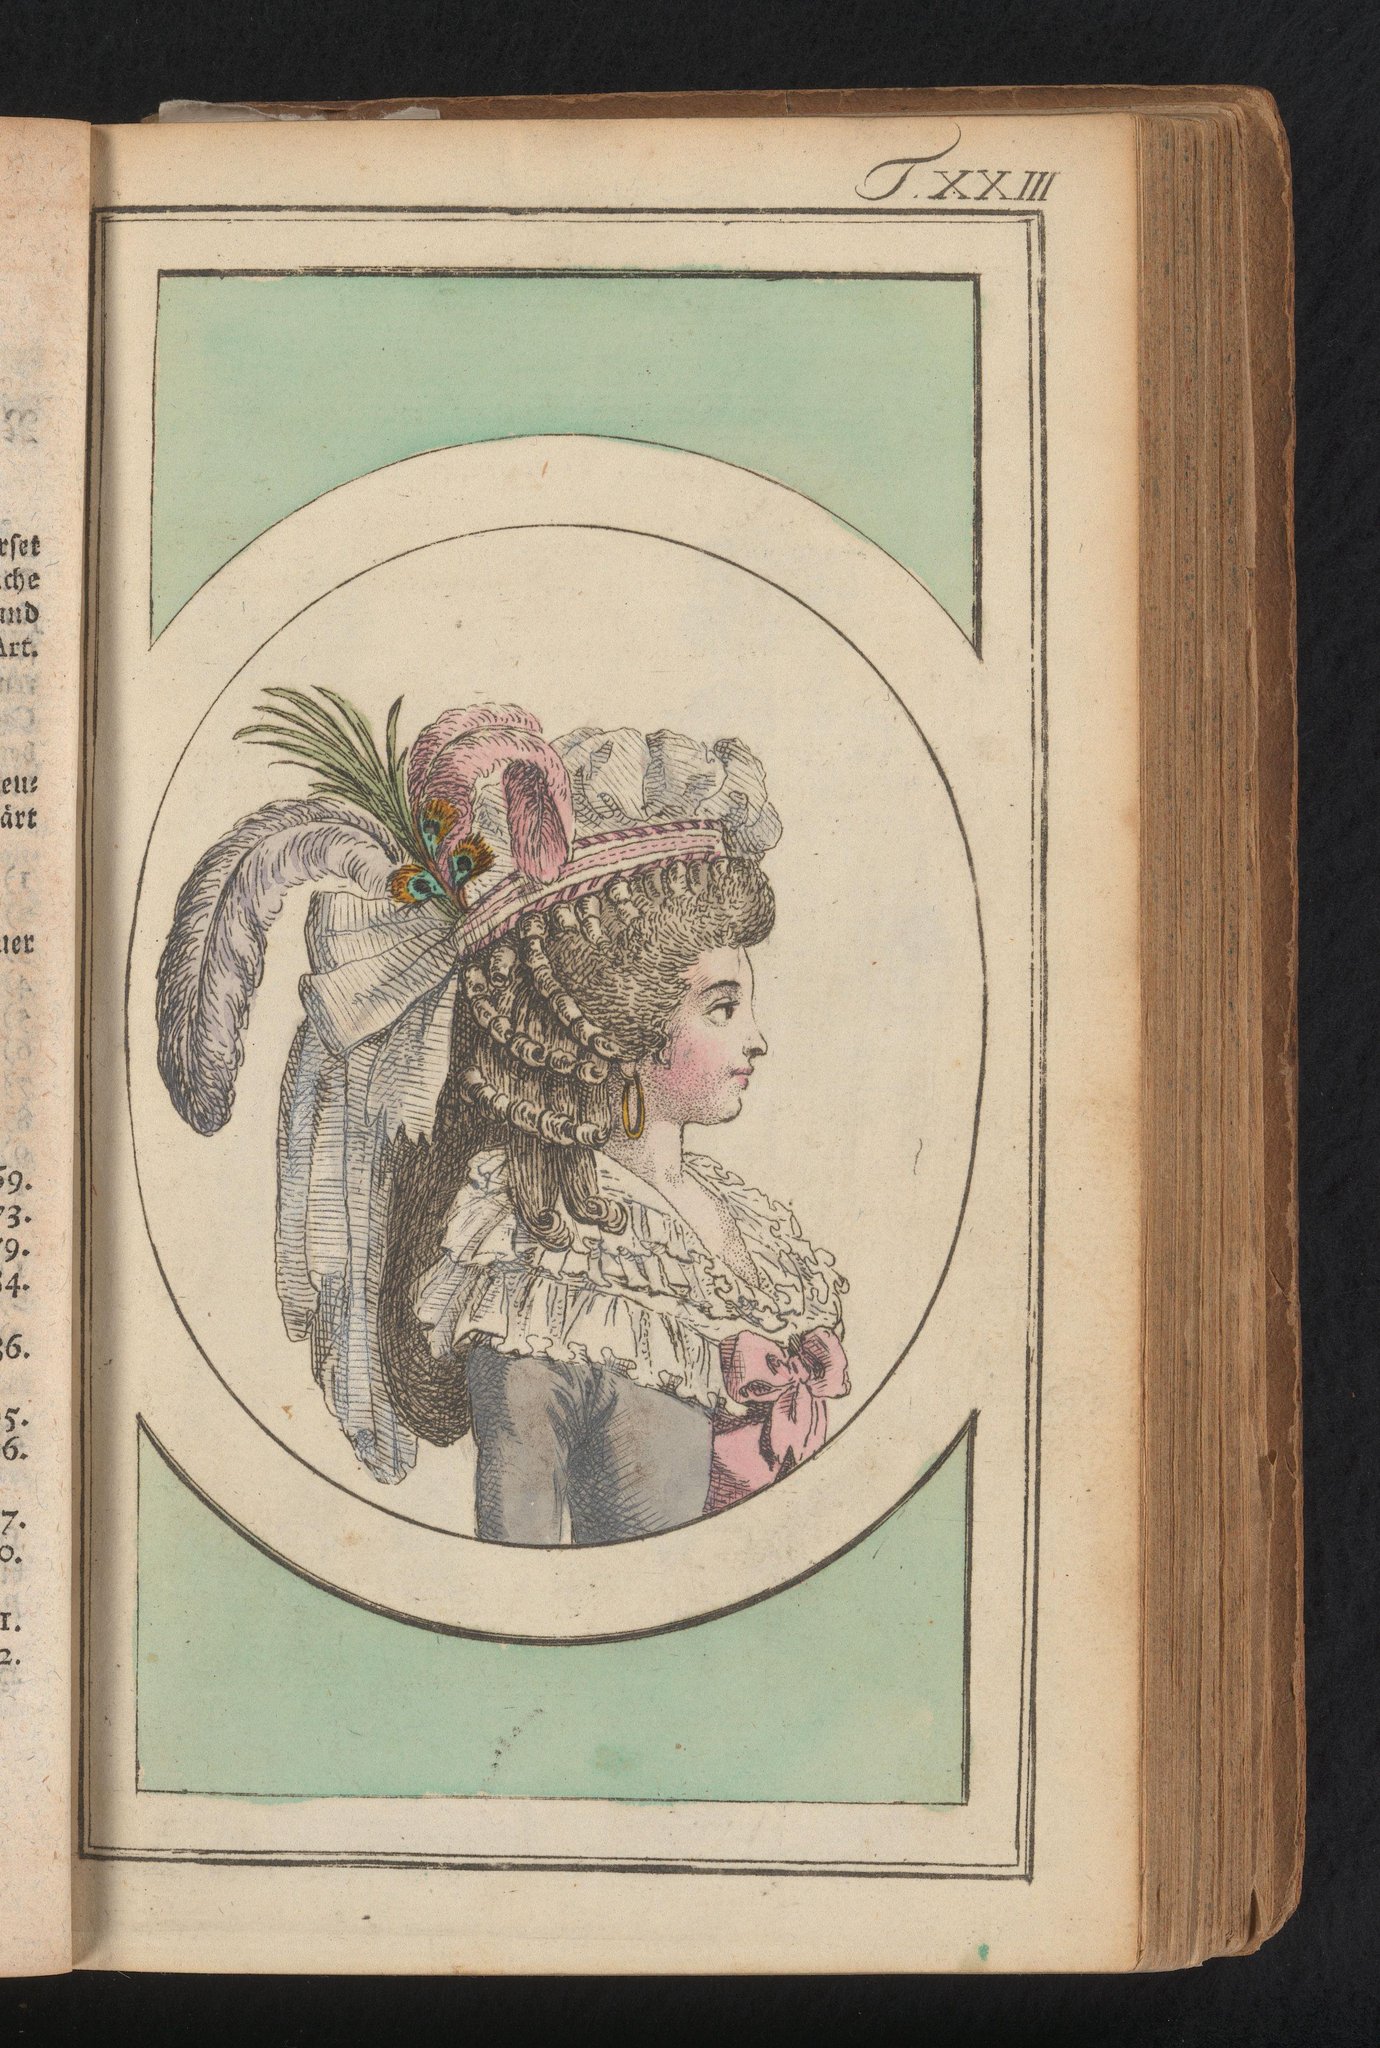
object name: fashion print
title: Journal des Luxus und der Moden 1786, Band I, T. 23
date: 1786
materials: paper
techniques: etching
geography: weimar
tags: fashion plates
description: Vrouwenbuste naar rechts in een grijze 'Juste' met een roze strik op de borst. Gegarneerde fichu van wit linnen. Een modern kapsel van Monsieur Depain en een 'Pouf' van Demoiselle Roussaud, beiden werkzaam in Parijs. Het kapsel bestaat uit rijen stijve krulletjes met aan weerszijden twee losse krullen die op de borst vallen. Van achteren een platte chignon. De pouf in van witte kant, gegarneerd met een roze lint, een roze en een witte veer, een sluier en een aigrette van pauwenveren. Prent uit het modetijdschrift Journal des Luxus und der Moden, uitgegeven door Friedrich Justin Bertuch en Georg Melchior Kraus, Weimar, 1786-1826.